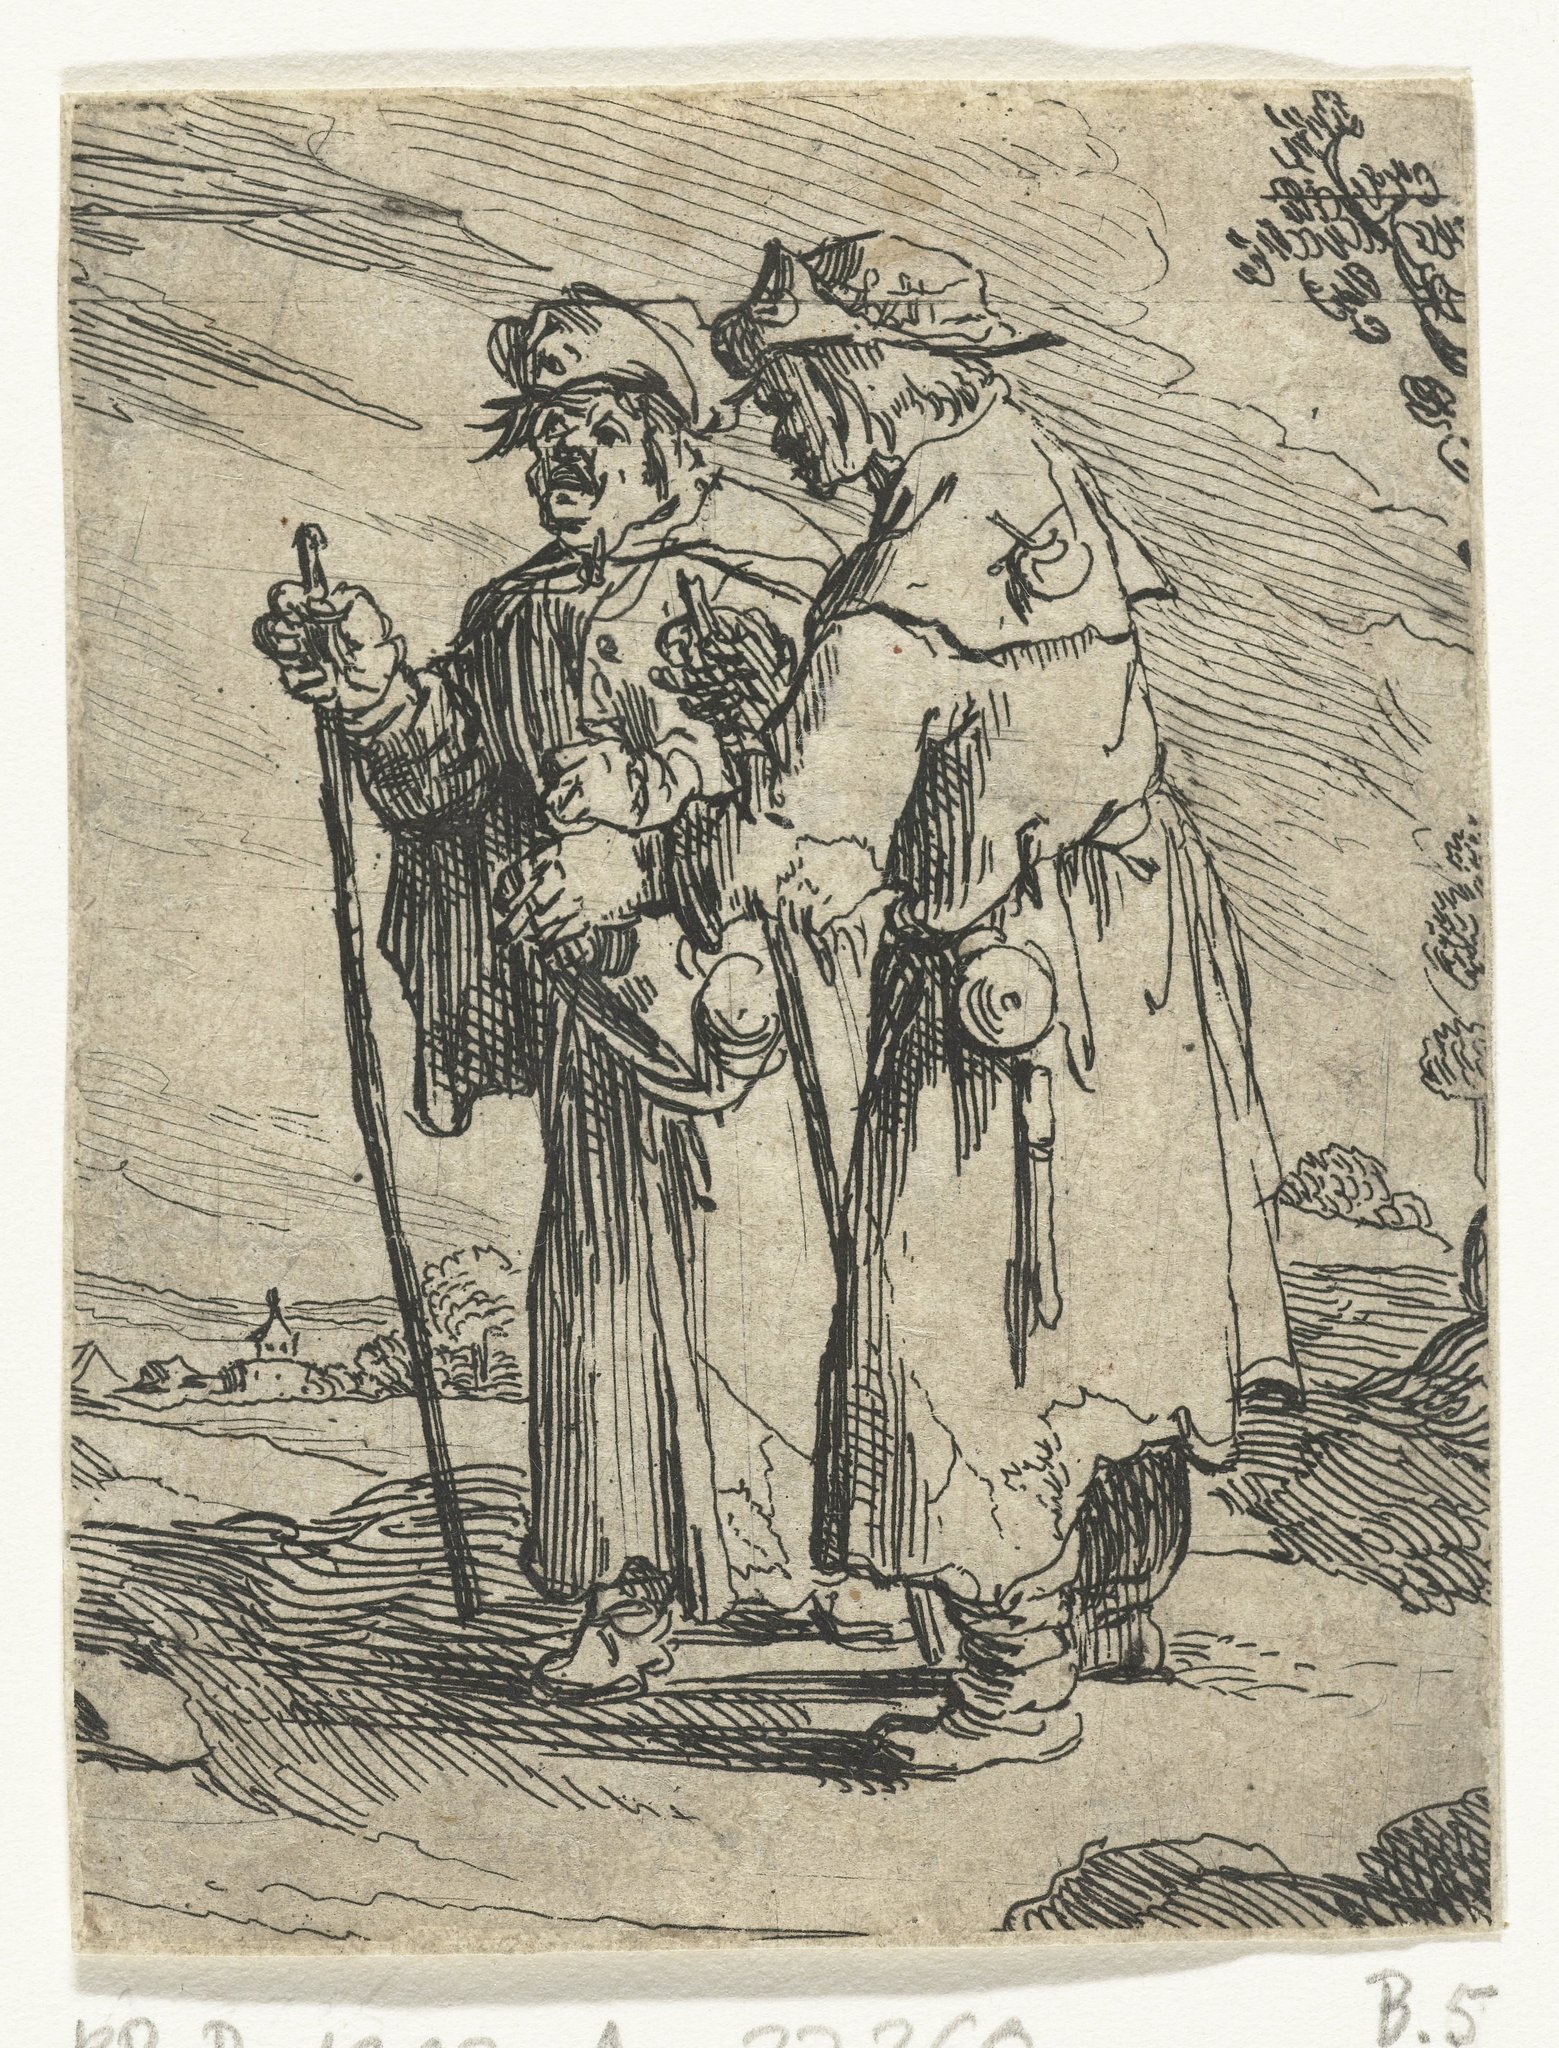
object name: print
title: Twee pelgrims op de weg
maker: andries both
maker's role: draughtsman, painter, print maker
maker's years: 1612-1642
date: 1622-1642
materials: paper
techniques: etching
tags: pilgrim(s)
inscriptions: collector's mark: Lugt 2228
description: Twee mannen met pelgrimsstaven en hoeden lopen naast elkaar op een weg.